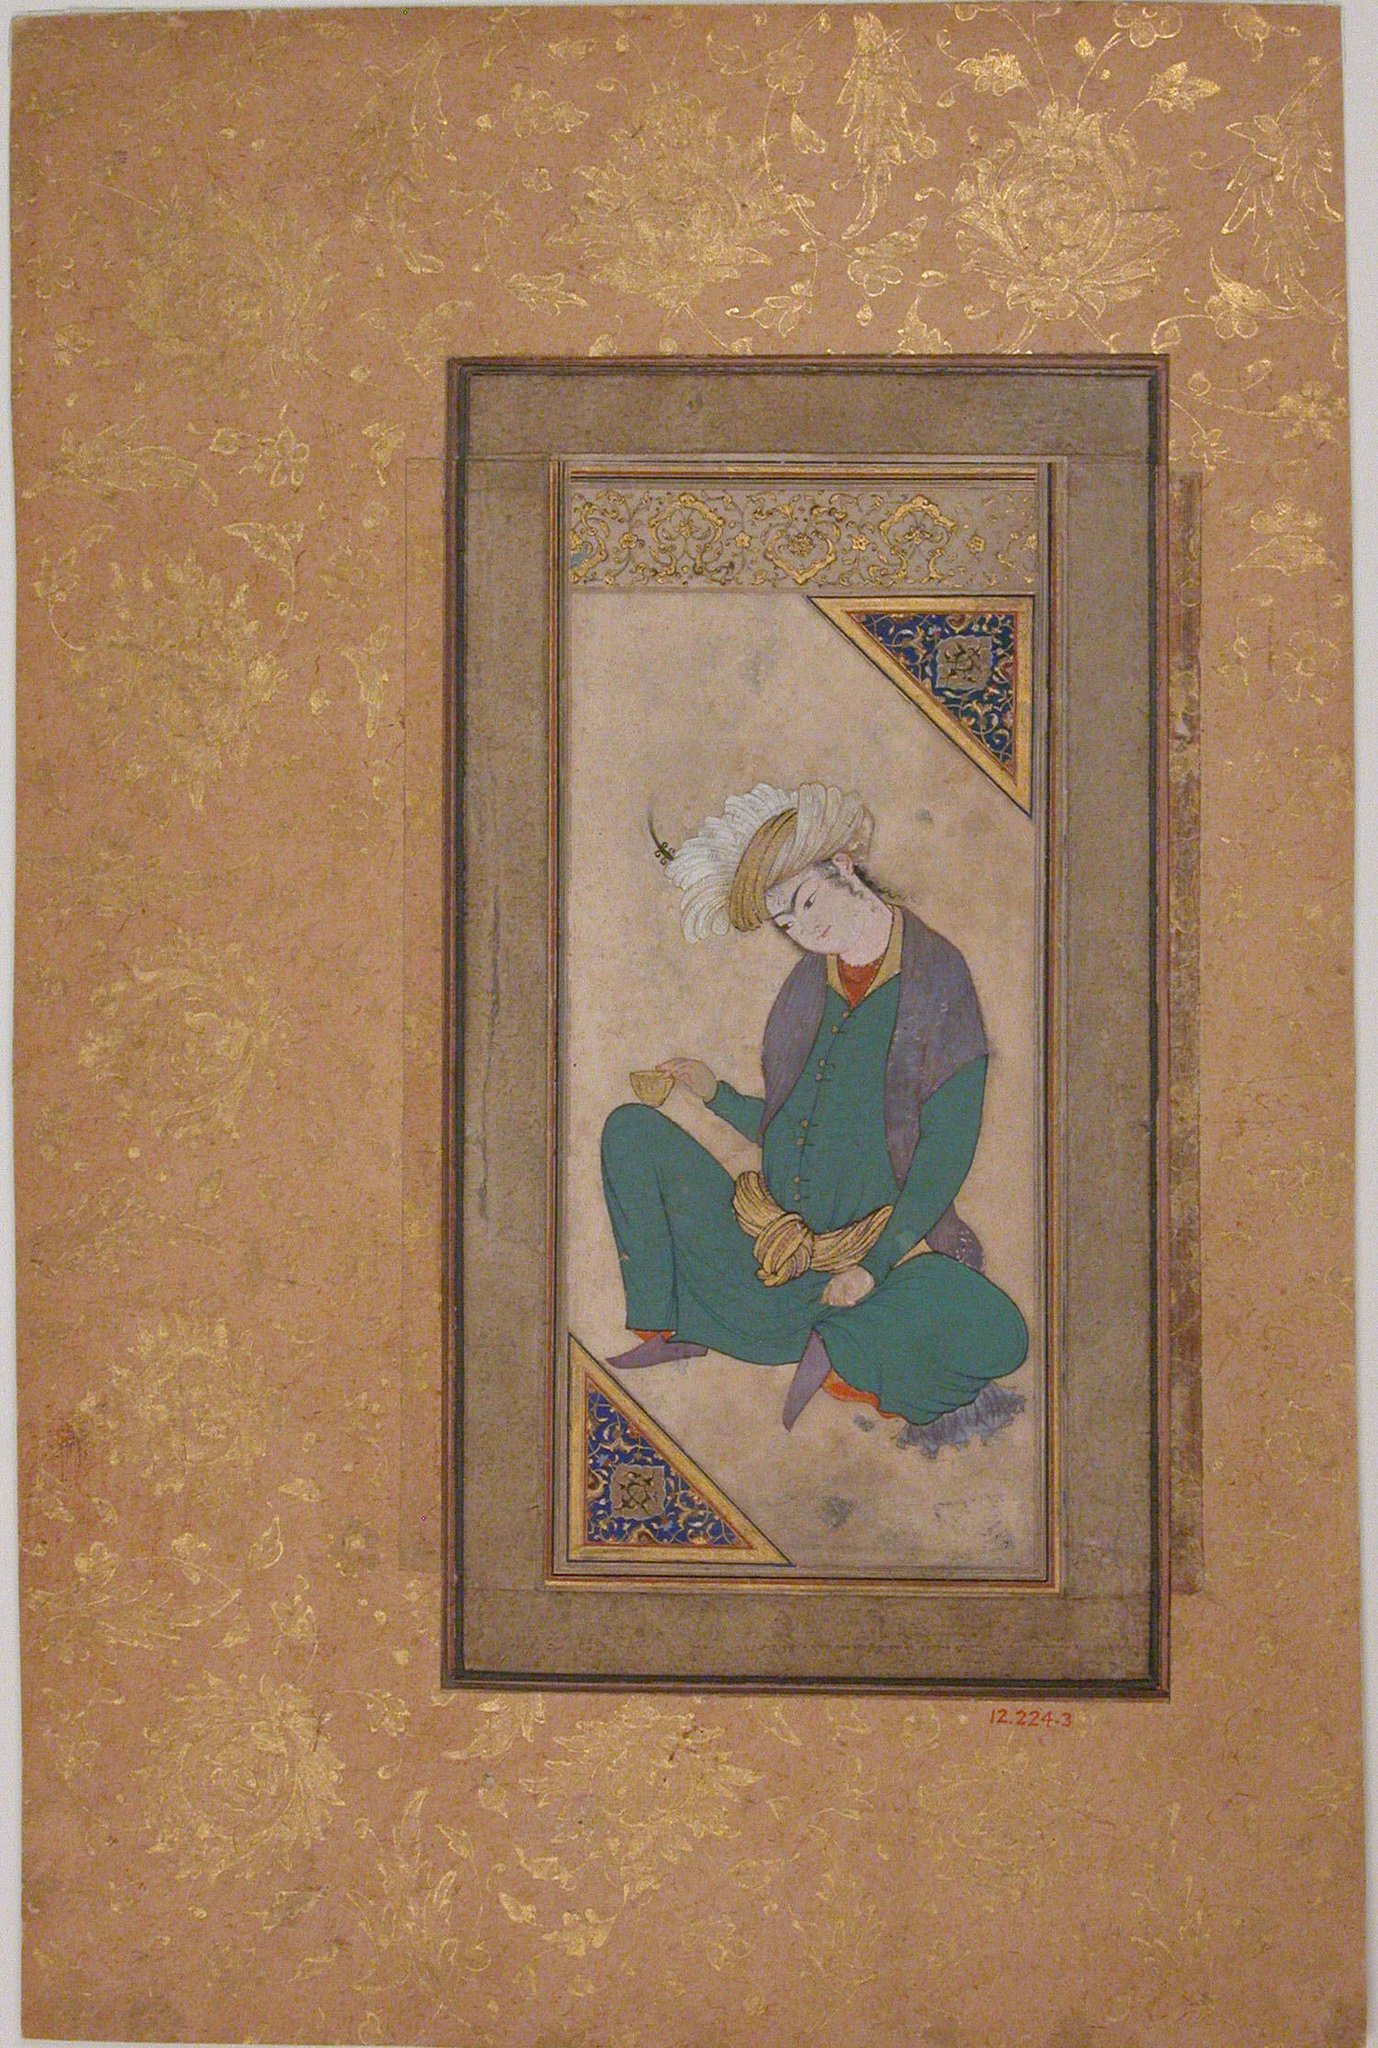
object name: illustrated album leaf or single work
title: Seated Youth with a Cup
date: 1567-1633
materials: gold, ink, paper, watercolor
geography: iran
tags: boys,cups